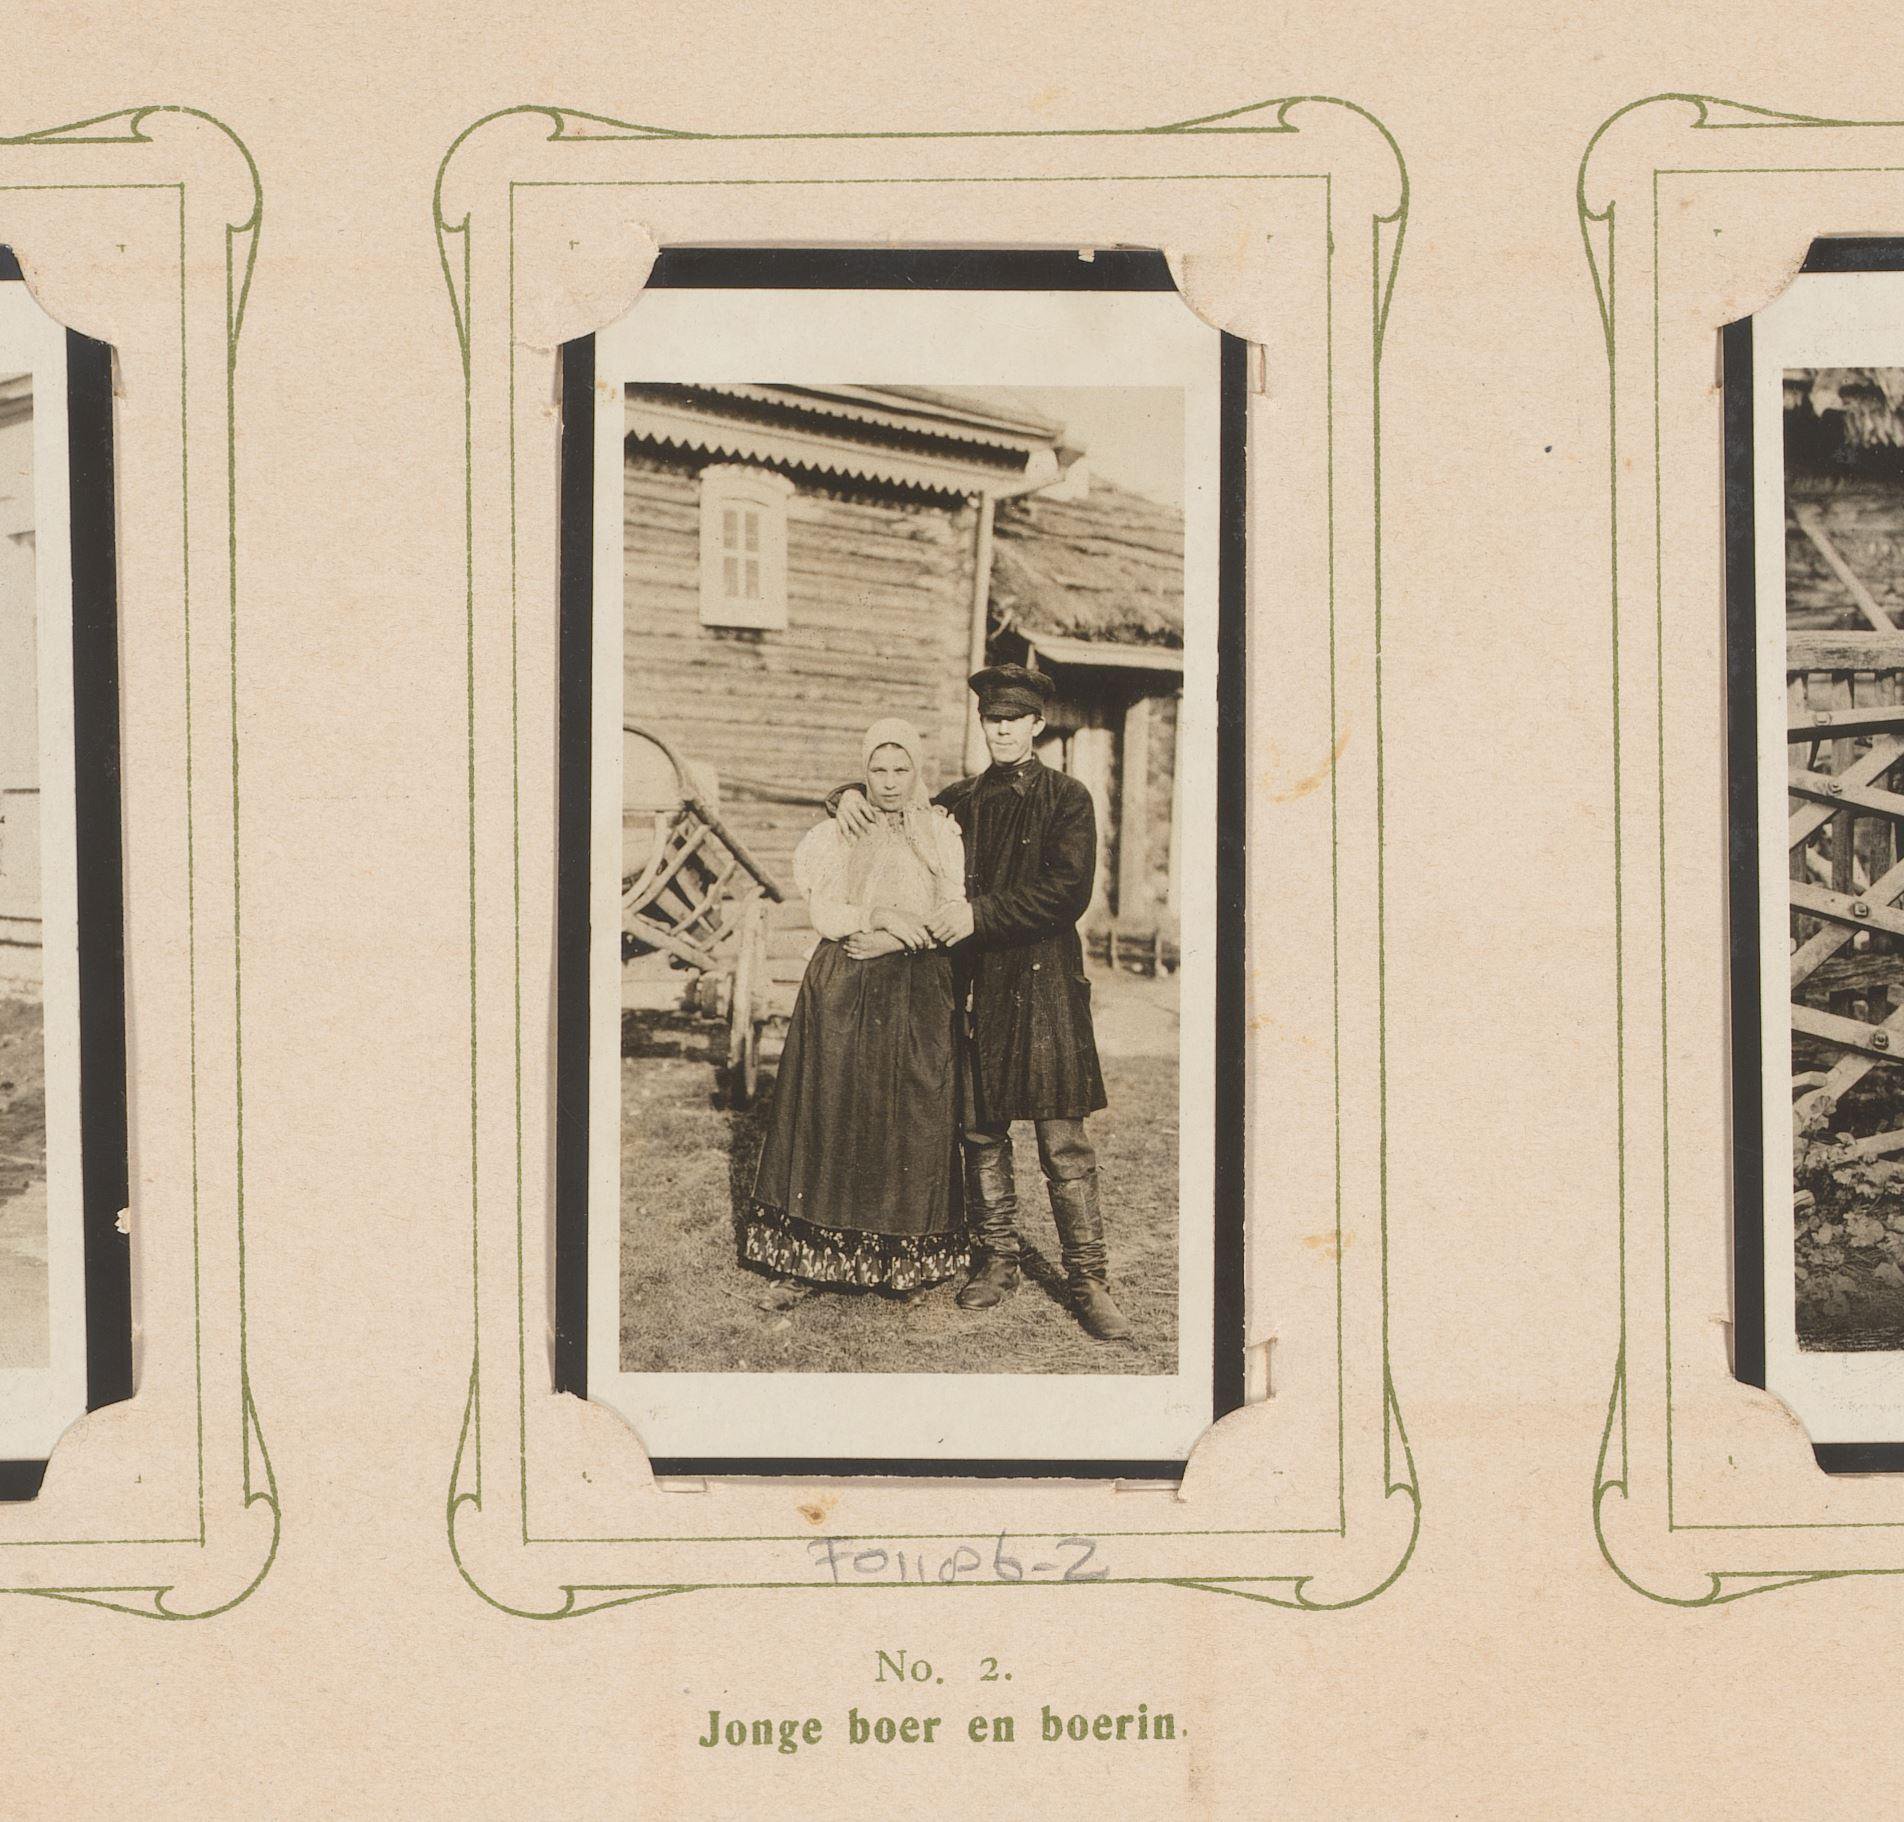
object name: album leaf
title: Russische boer en boerin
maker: Anonymous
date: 1904-1905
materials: photographic support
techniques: gelatin silver print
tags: farmers, farmers - aa - female farmer, farmer's wife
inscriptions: inscription: ‘No. 2./ Jonge boer en boerin’